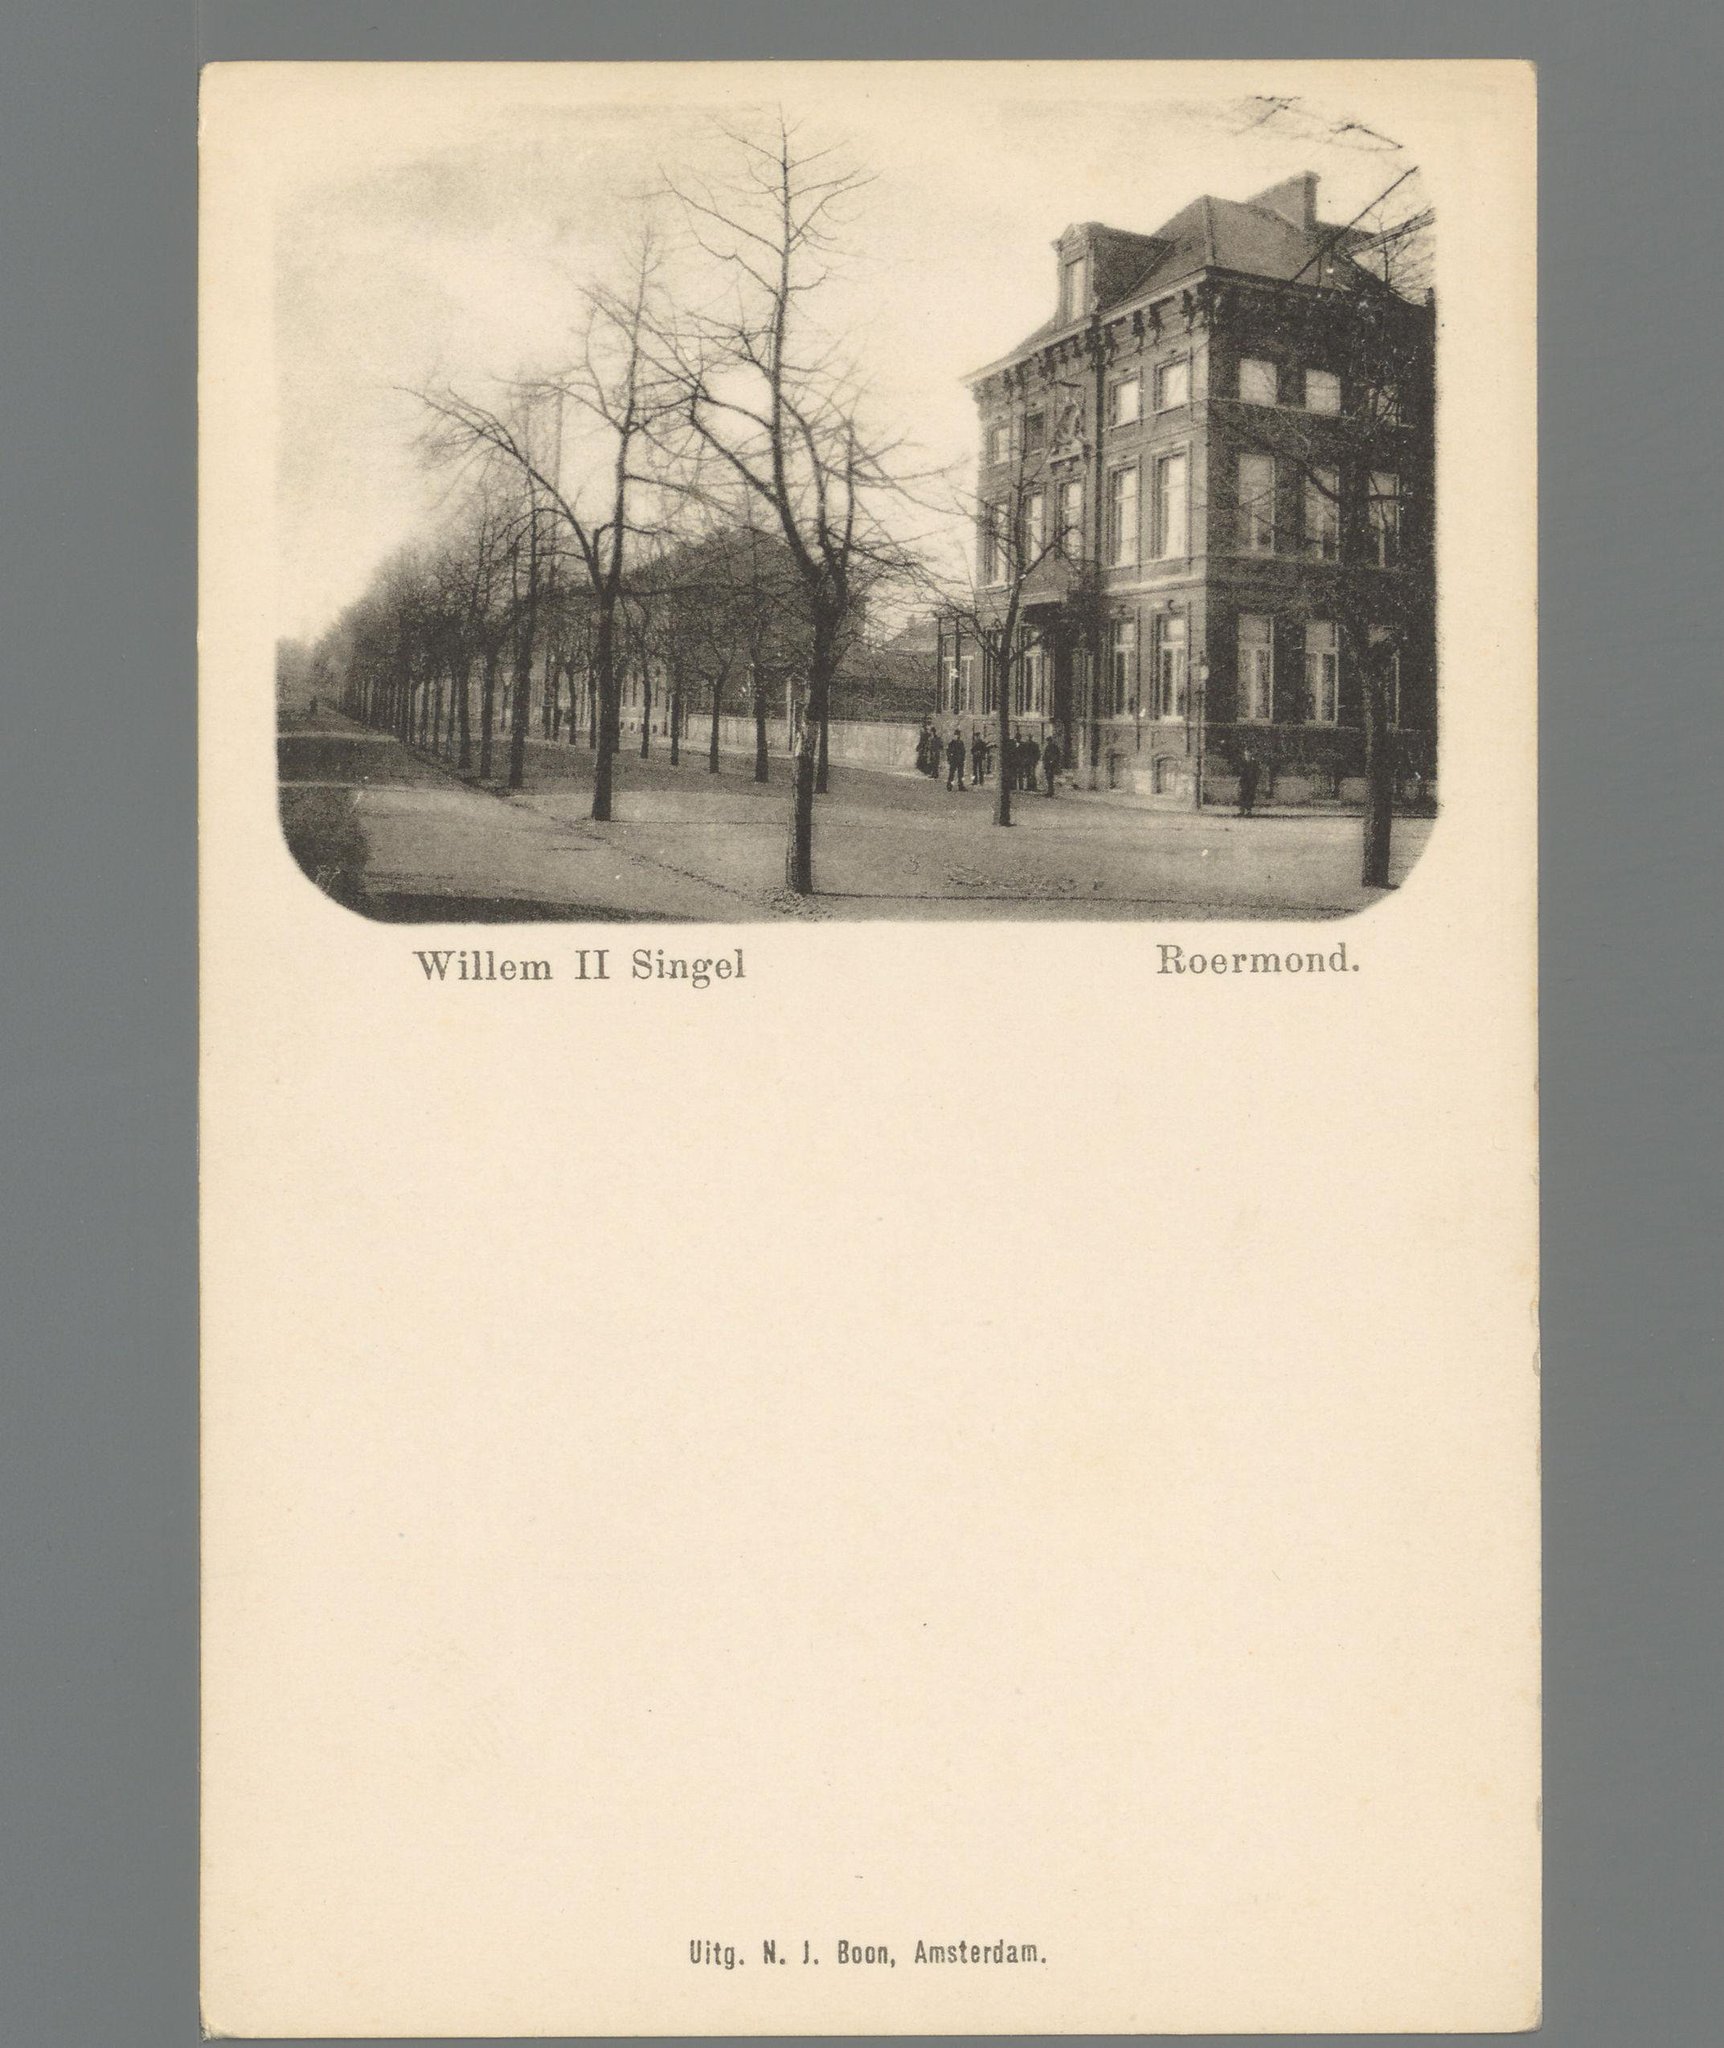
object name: photomechanical print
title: Willem II Singel. Roermond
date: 1895-1901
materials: cardboard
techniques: photograph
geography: amsterdam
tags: street